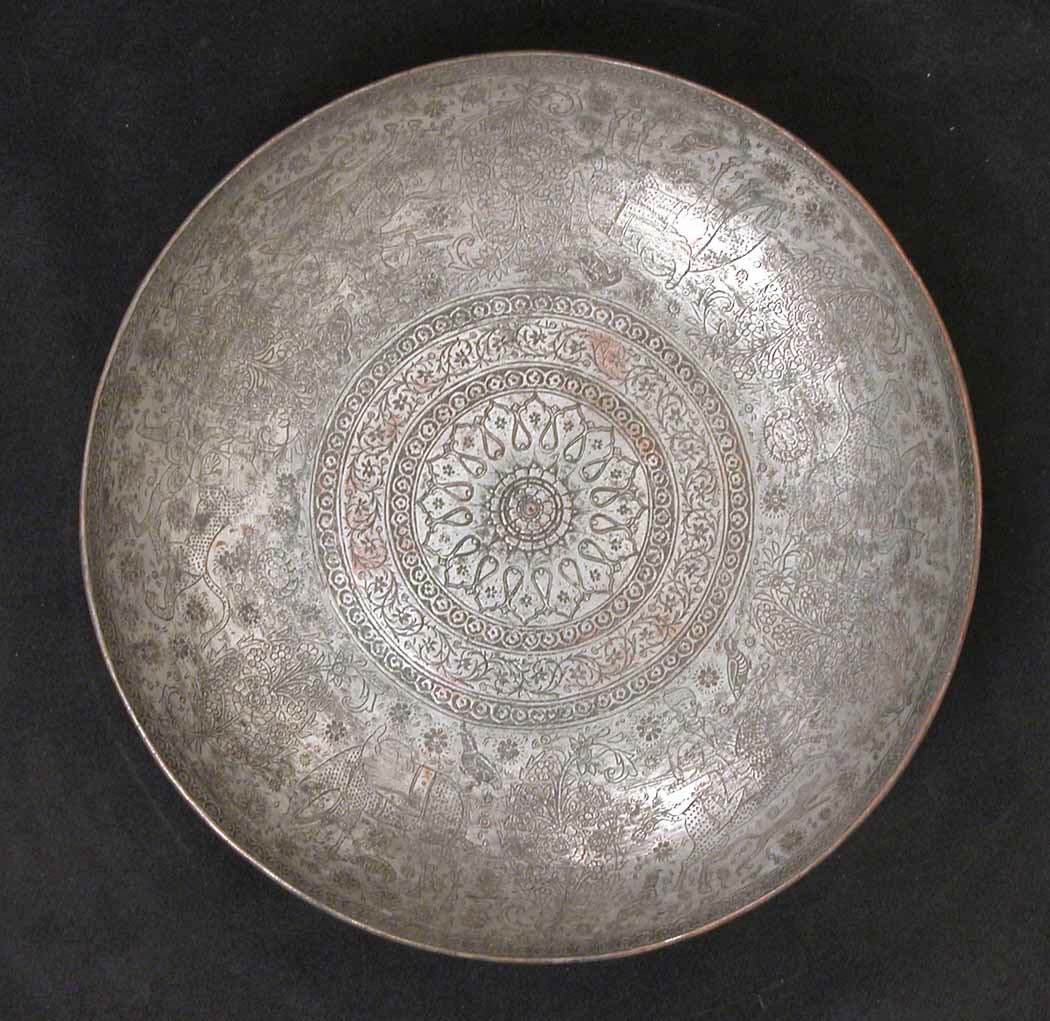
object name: dish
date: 1801-1900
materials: copper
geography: iran